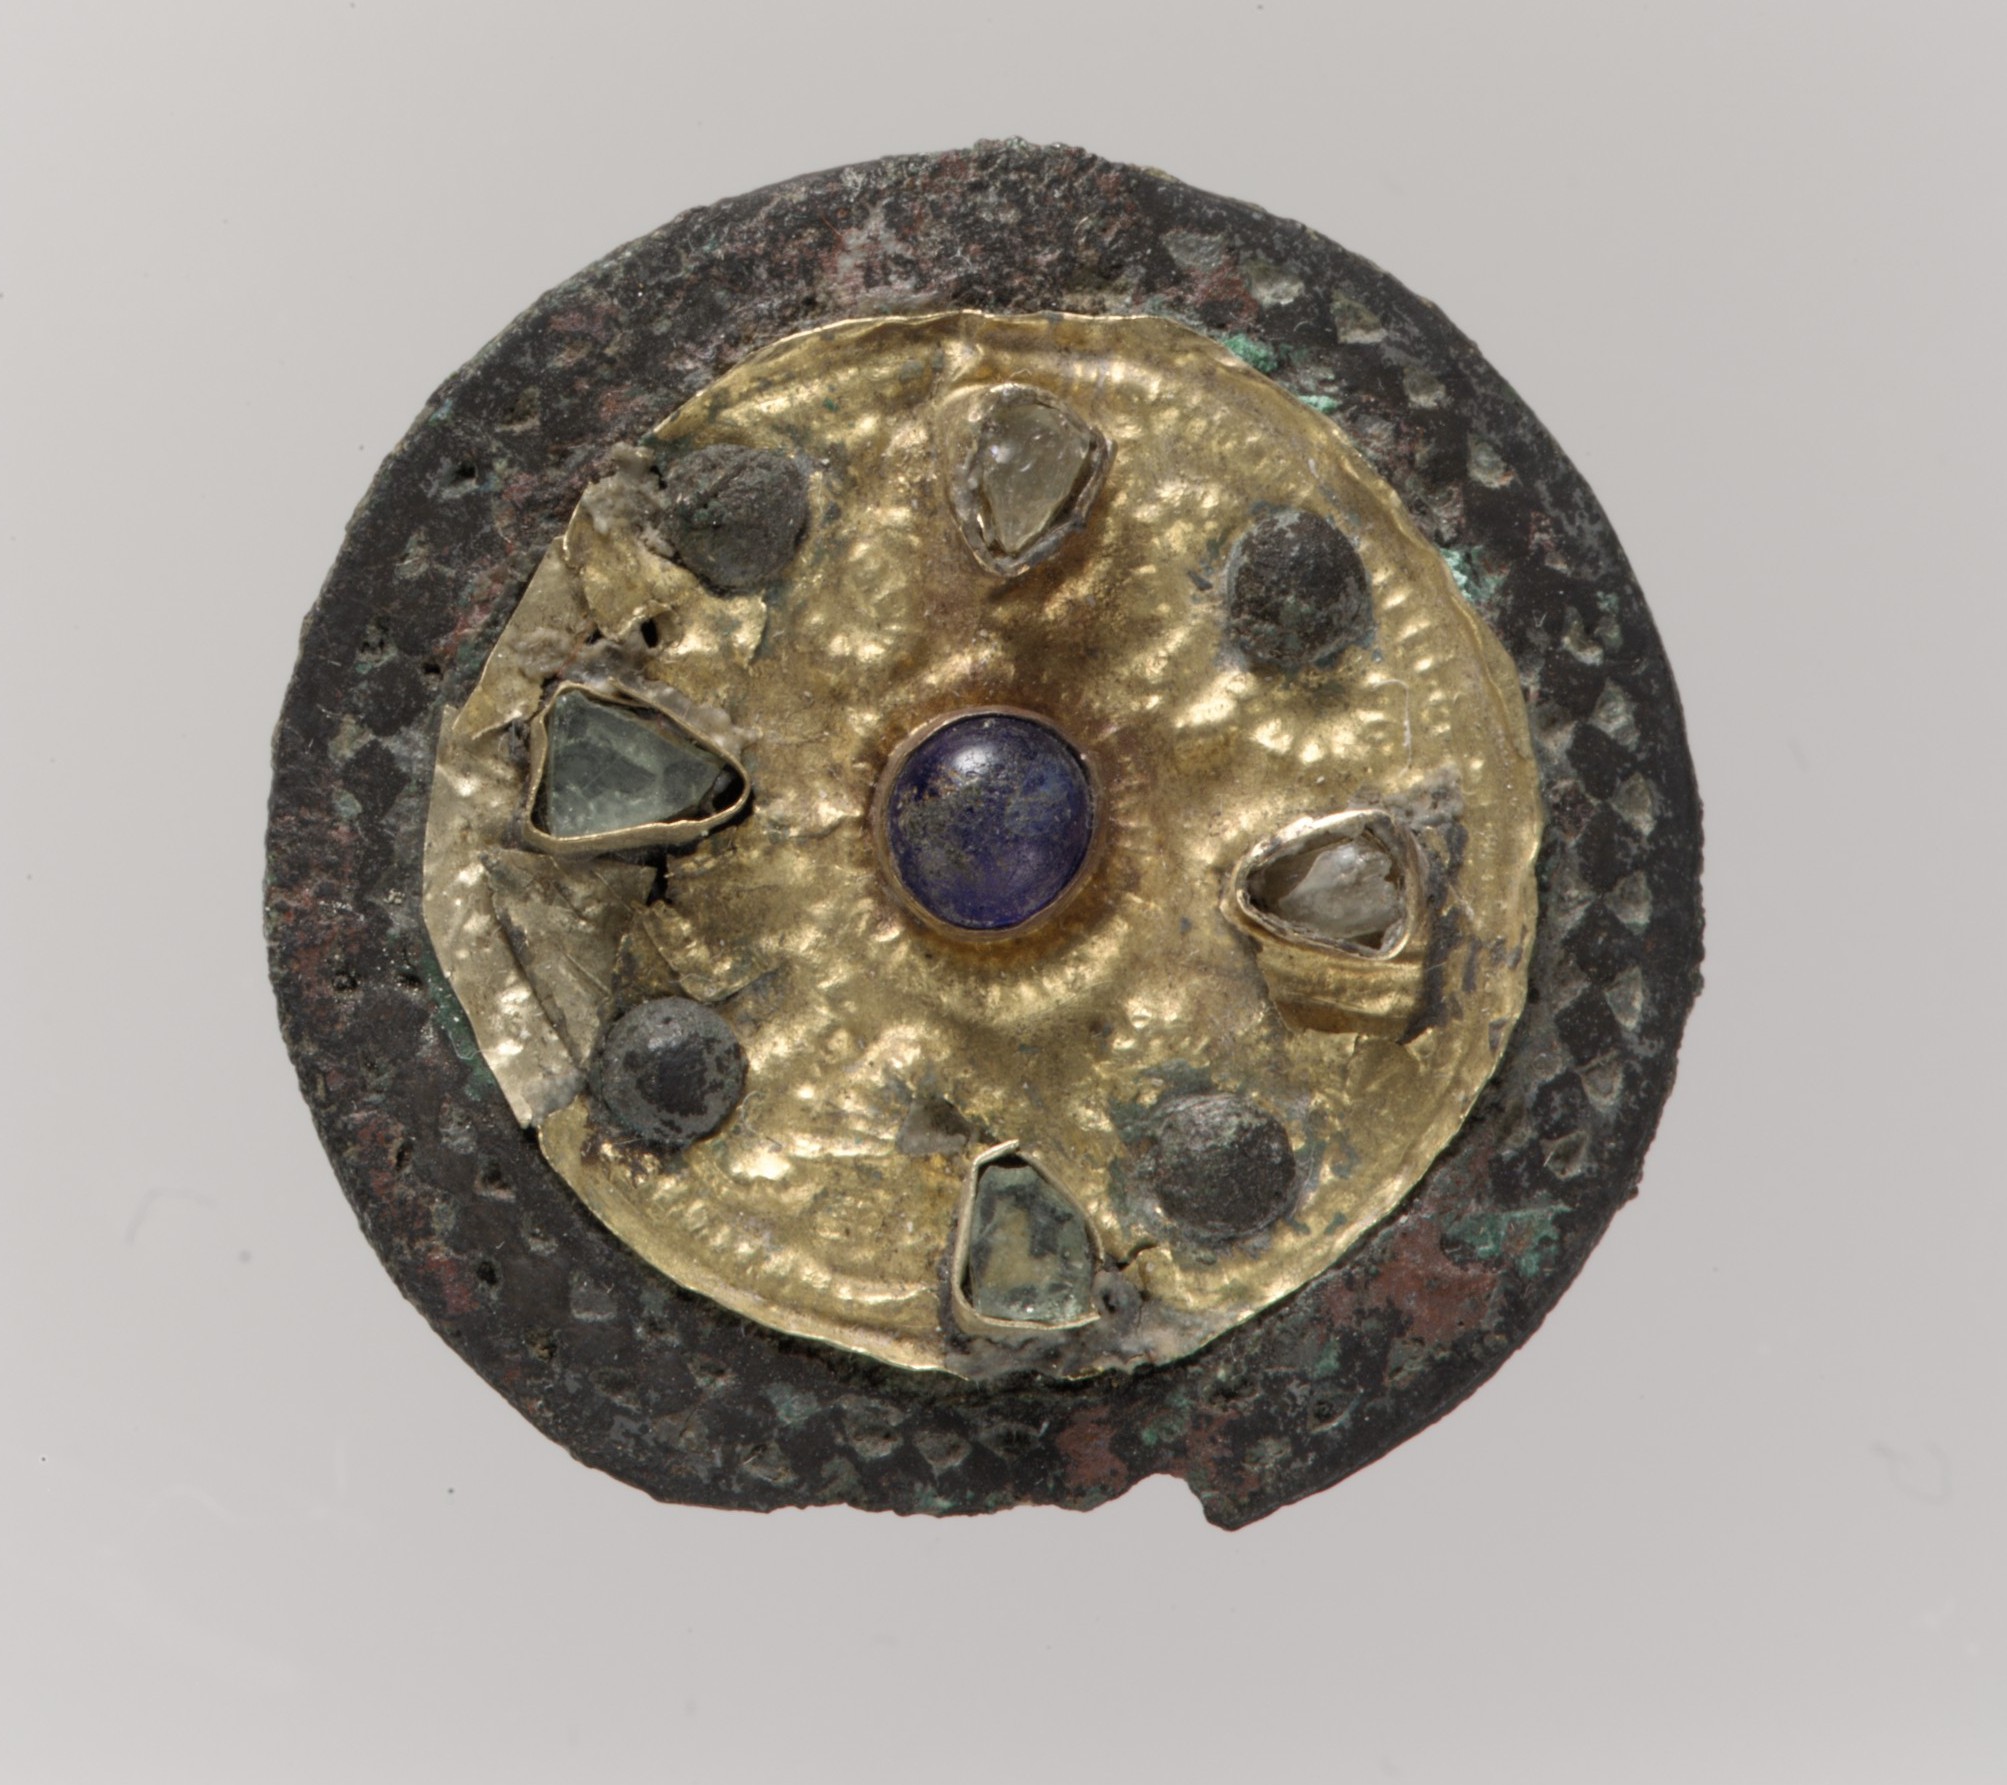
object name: brooch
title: Disk Brooch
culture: frankish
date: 550-650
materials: copper alloy, glass, gold, paste